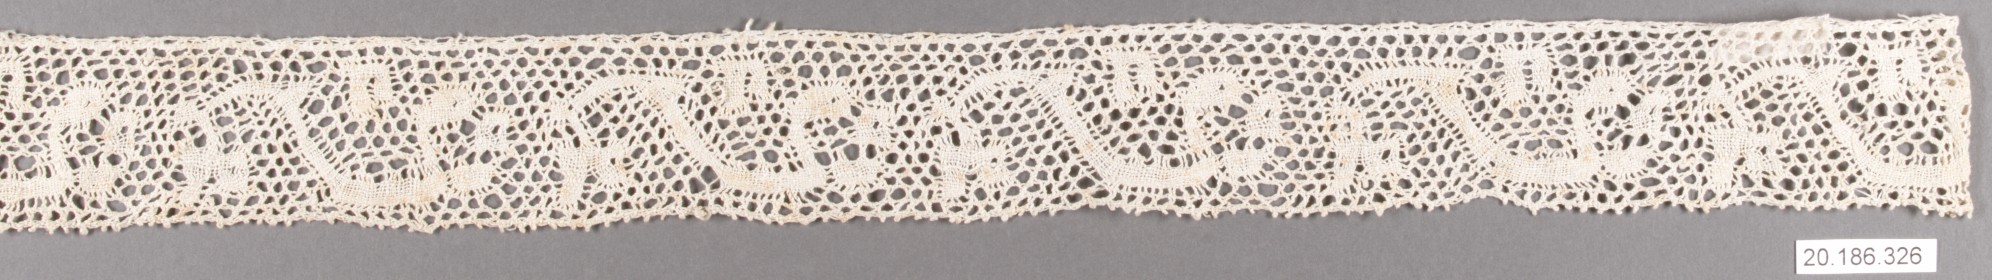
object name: strip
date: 1601-1700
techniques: lace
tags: dragons